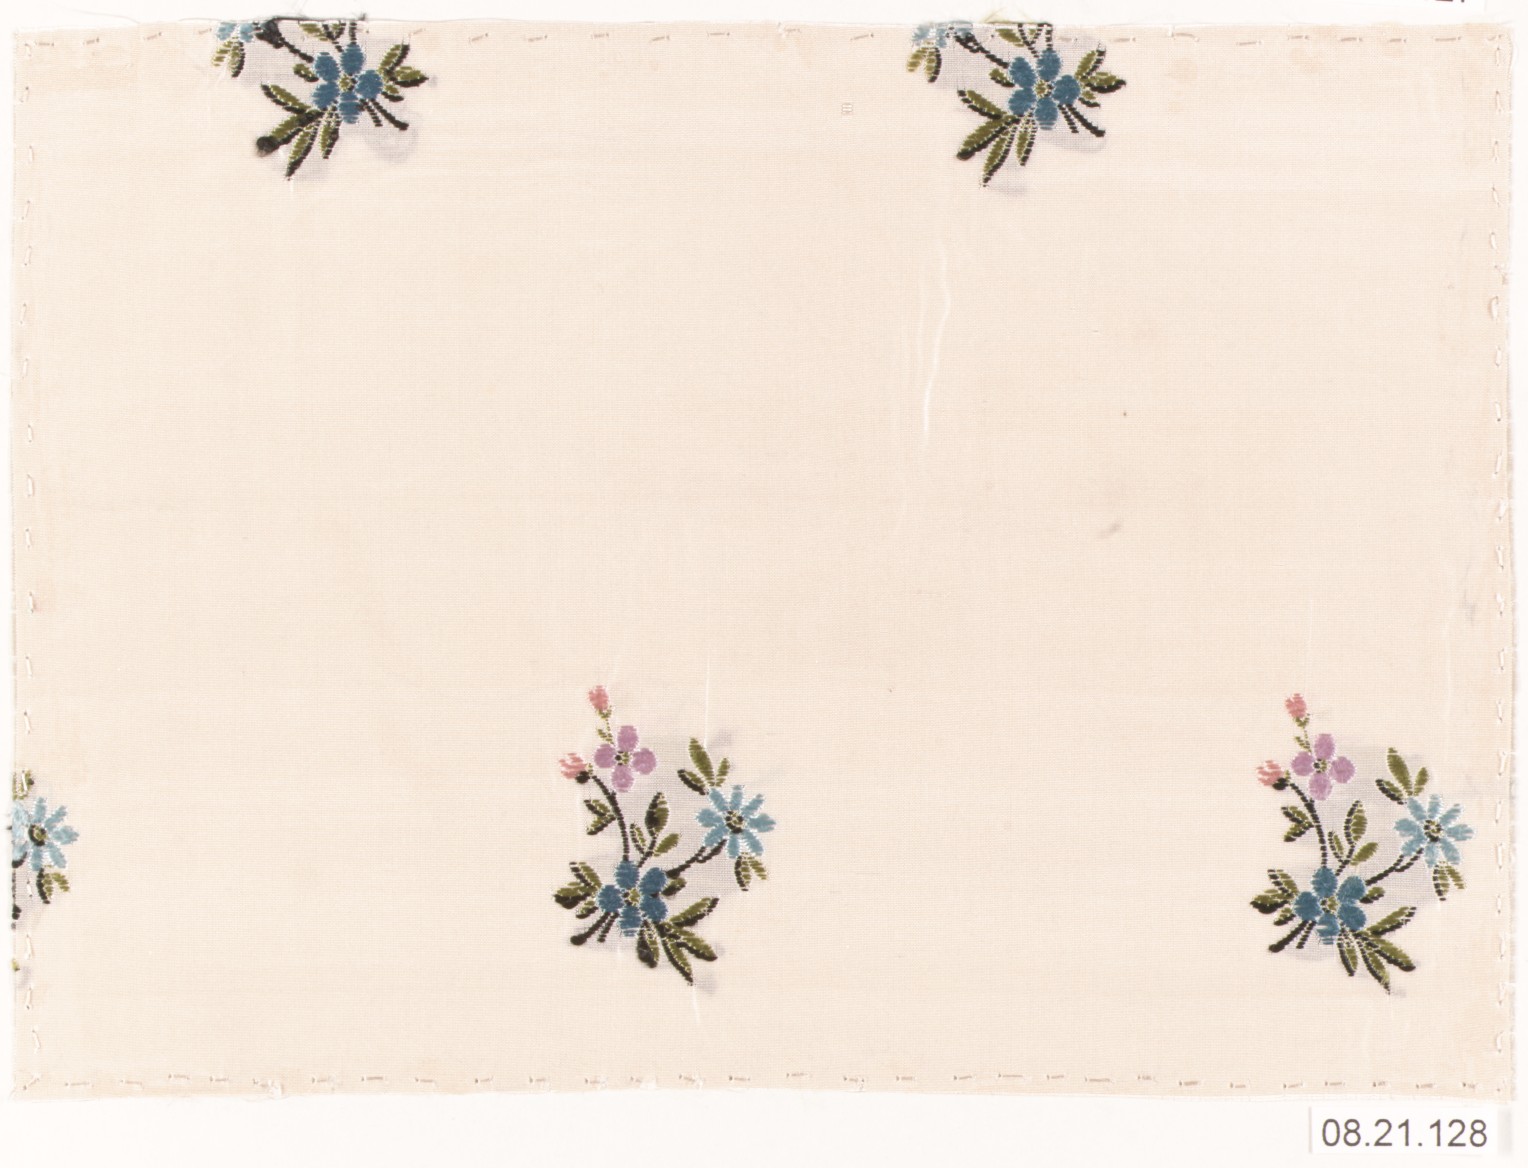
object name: textile sample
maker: Anonymous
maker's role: designer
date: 1900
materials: silk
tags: flowers